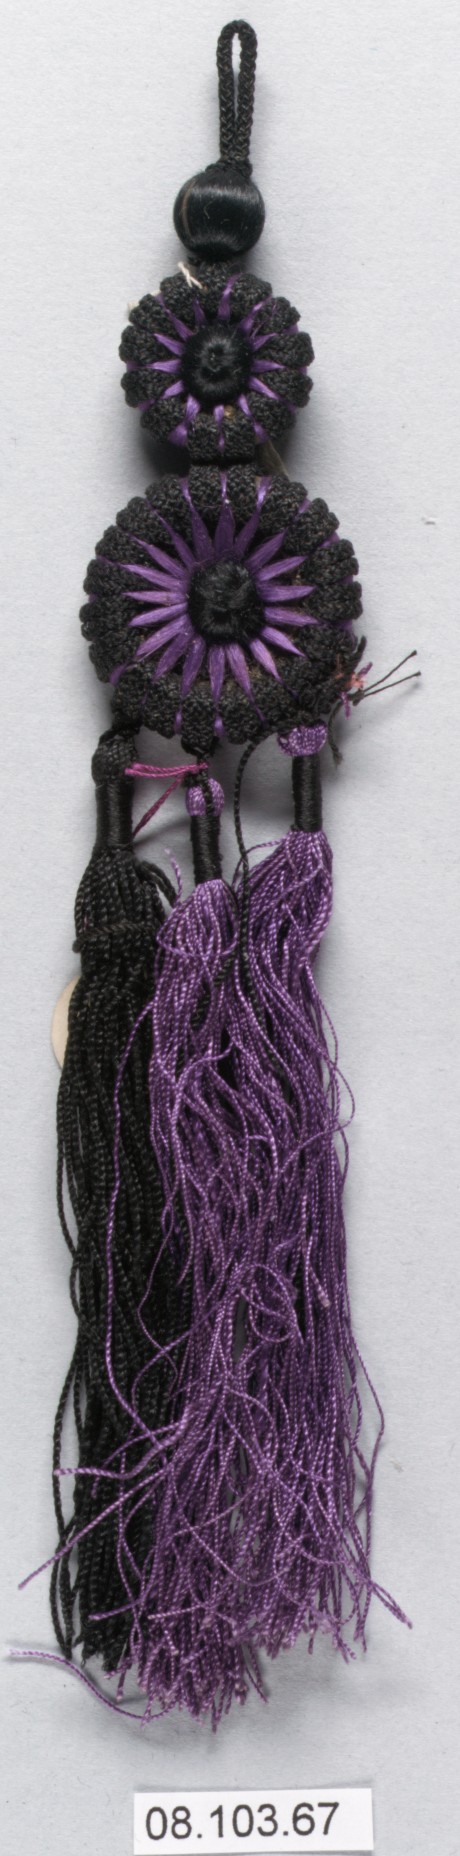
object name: tassel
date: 1801-1900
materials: silk